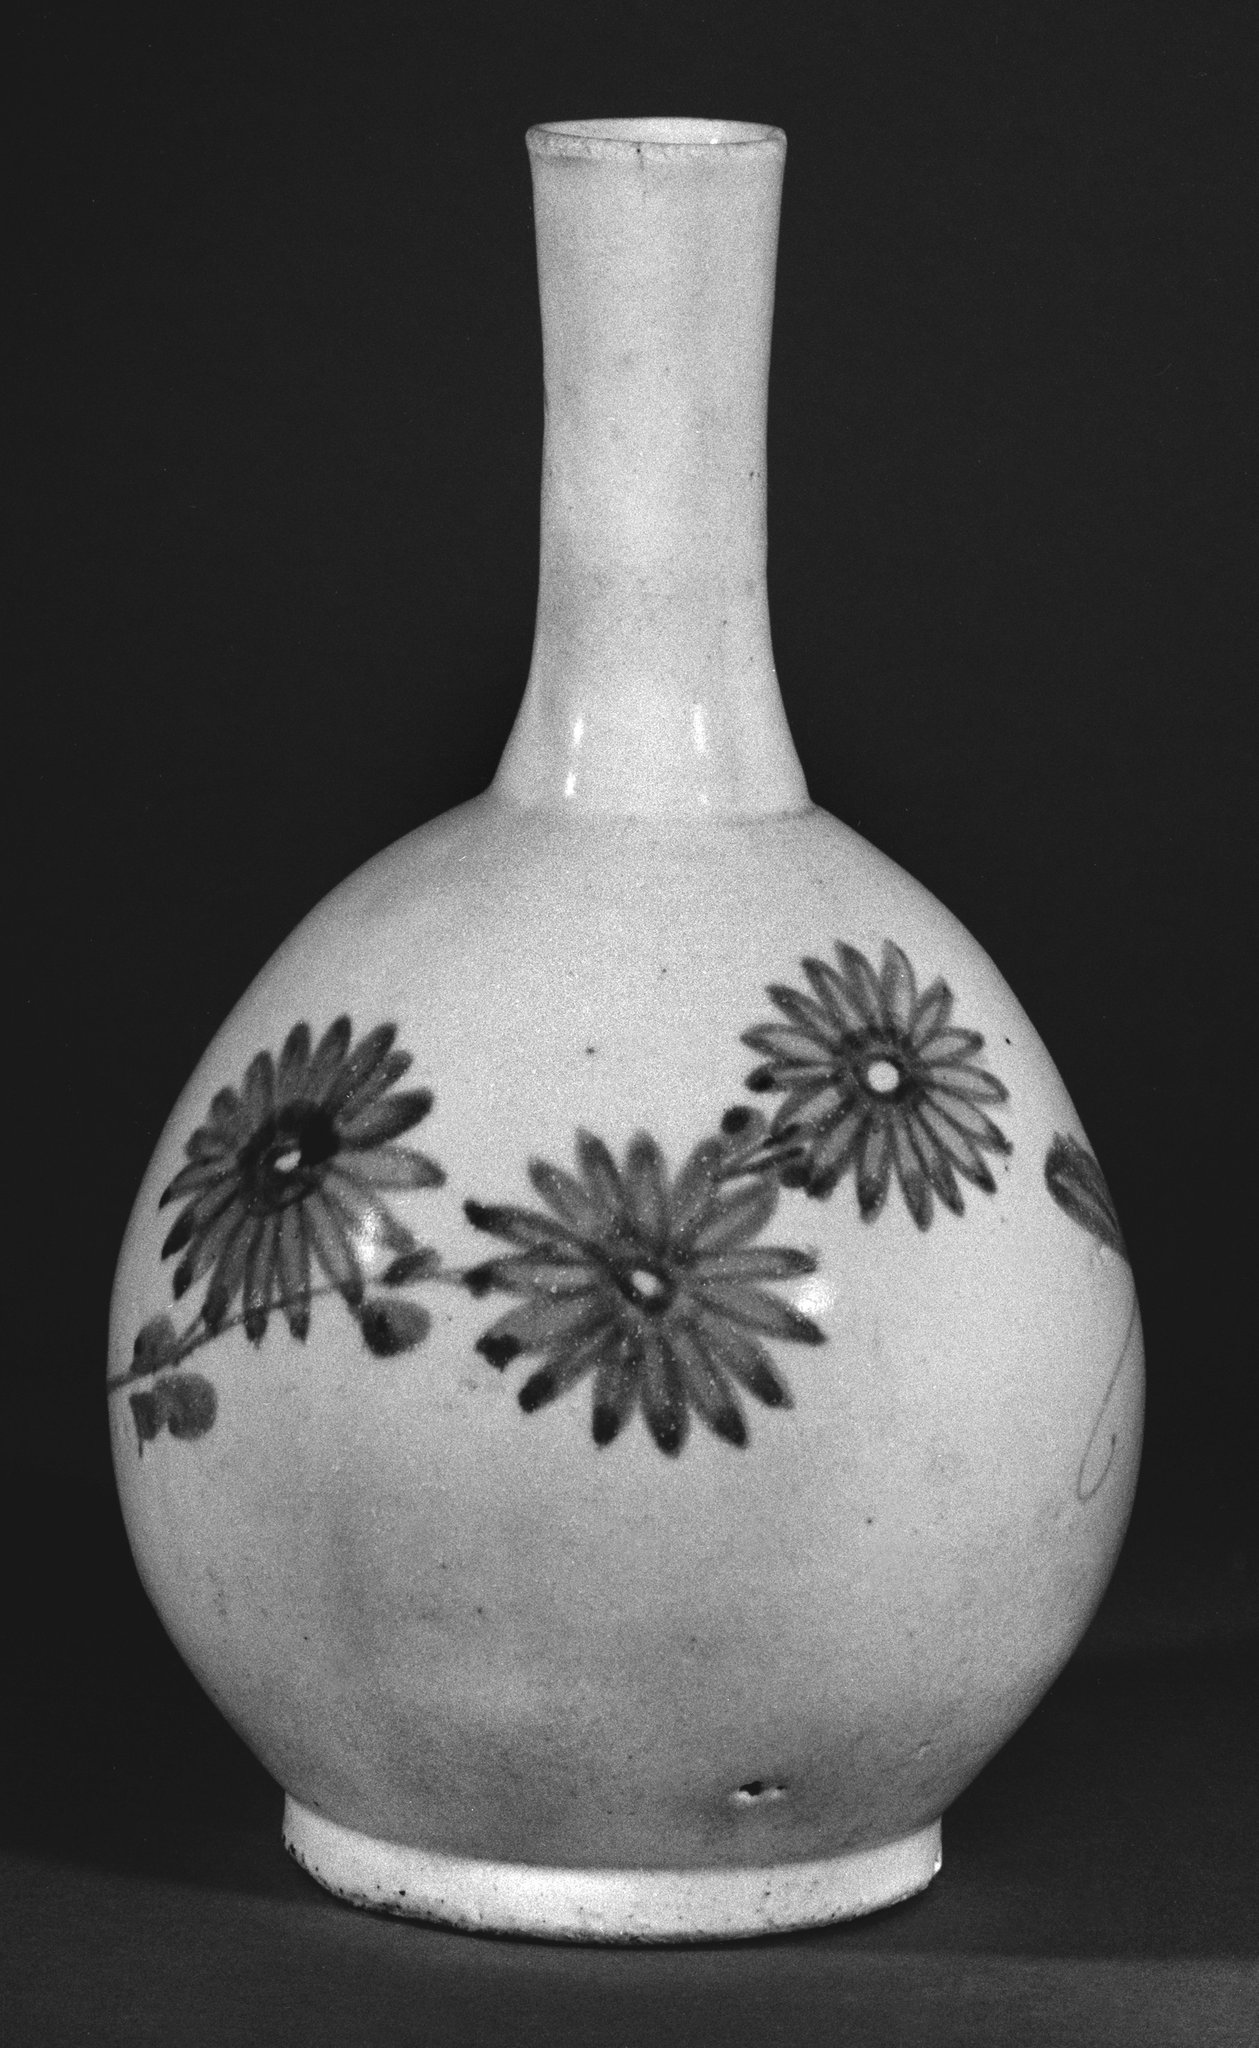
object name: bottle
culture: korean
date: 1601-1700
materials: stoneware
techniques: glazing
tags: flowers